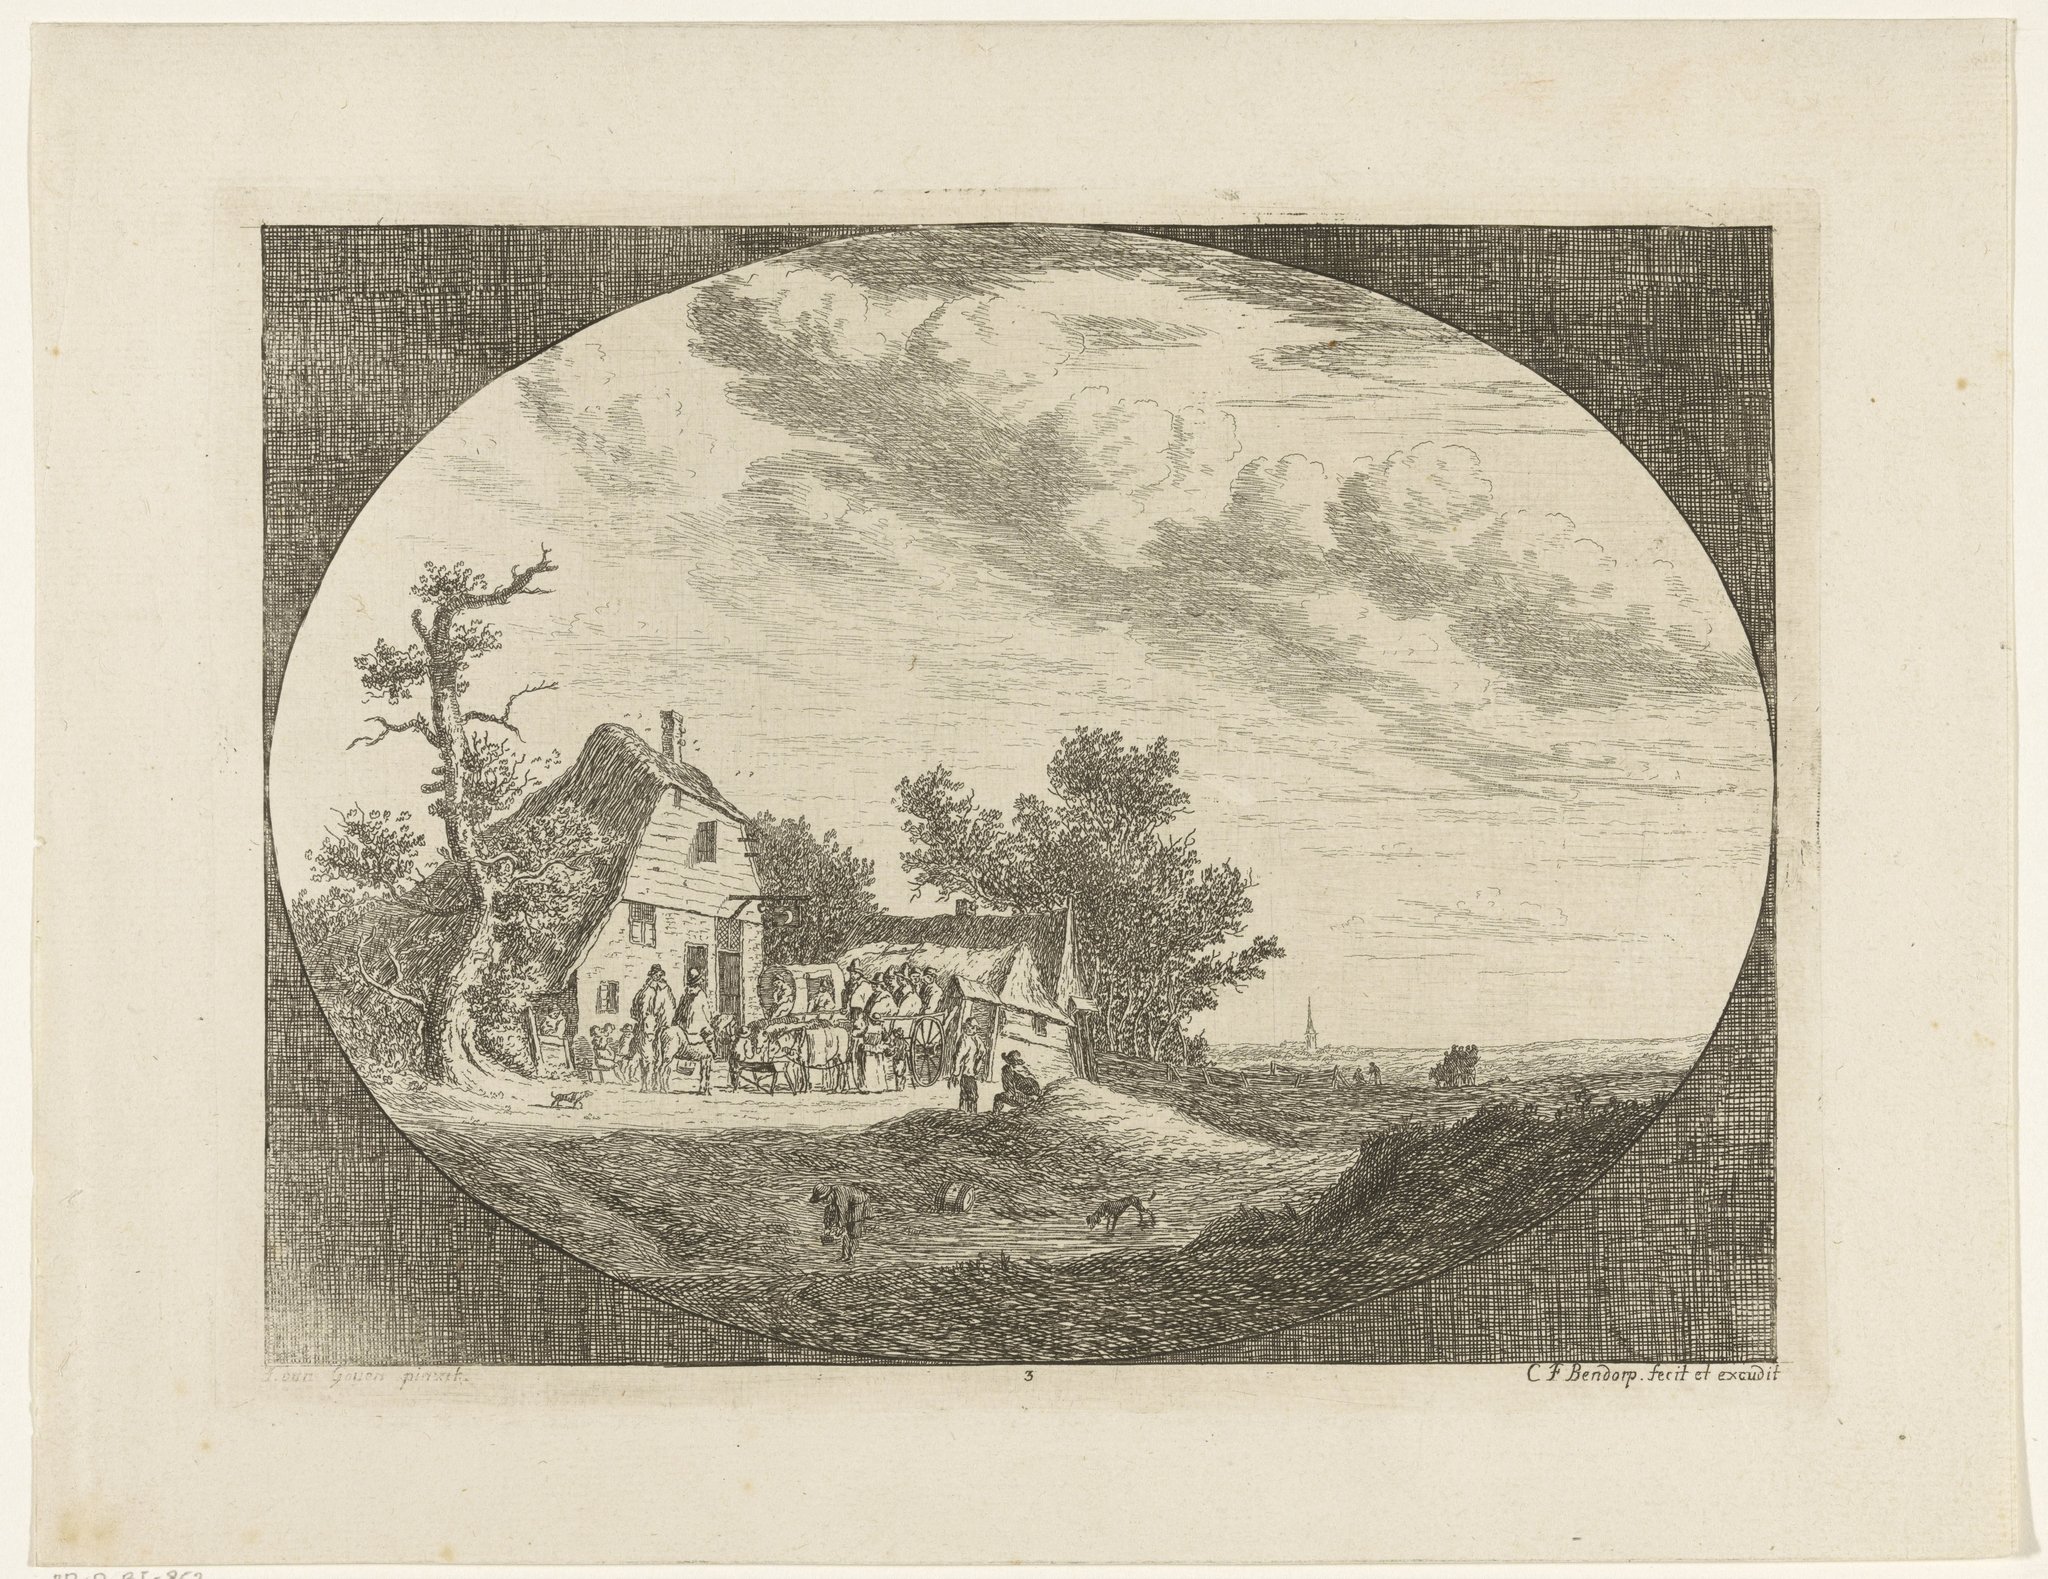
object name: print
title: Landschap met herberg en rustende paarden en wagens en ruiters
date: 1746-1814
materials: paper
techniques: etching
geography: netherlands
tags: four-wheeled, animal-drawn vehicle, e.g.: cab, carriage, coach, inn, coffee-house, public house, etc.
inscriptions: collector's mark: Lugt 240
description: Prent naar schilderij van Jan van Goyen.